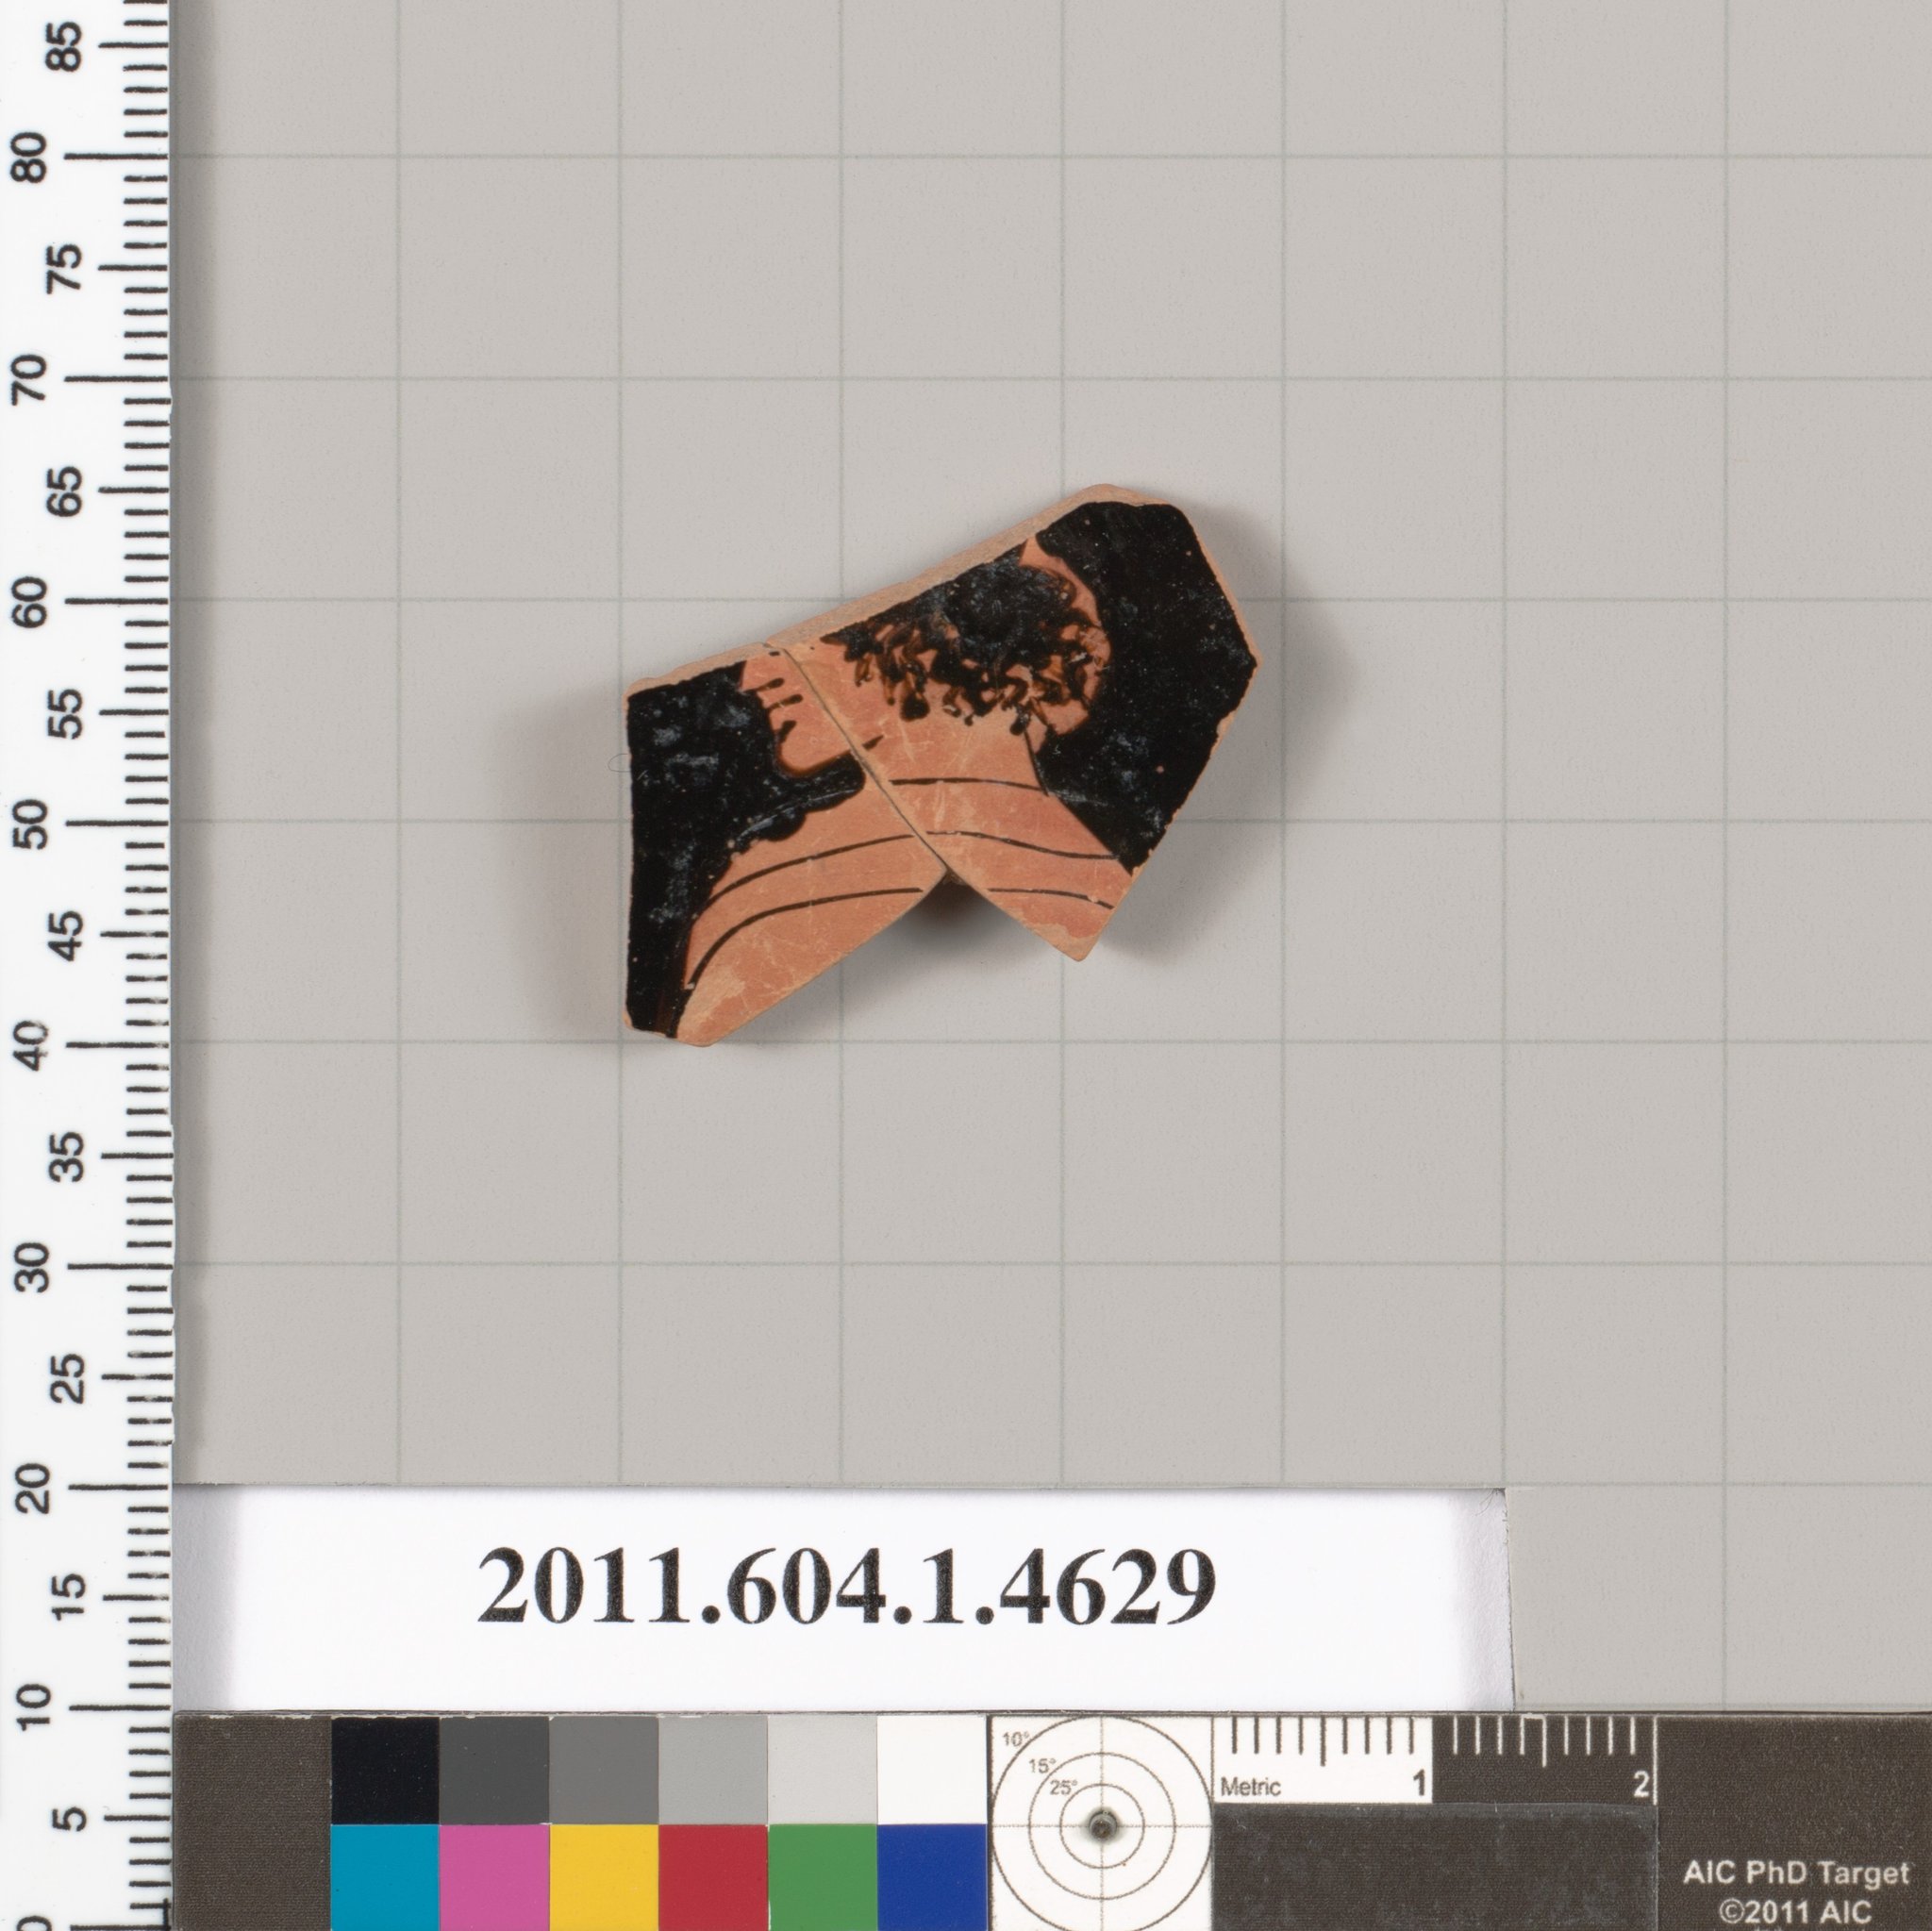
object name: kylix fragment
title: Terracotta fragment of a kylix (drinking cup)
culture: greek, attic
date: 460-450 BCE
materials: terracotta